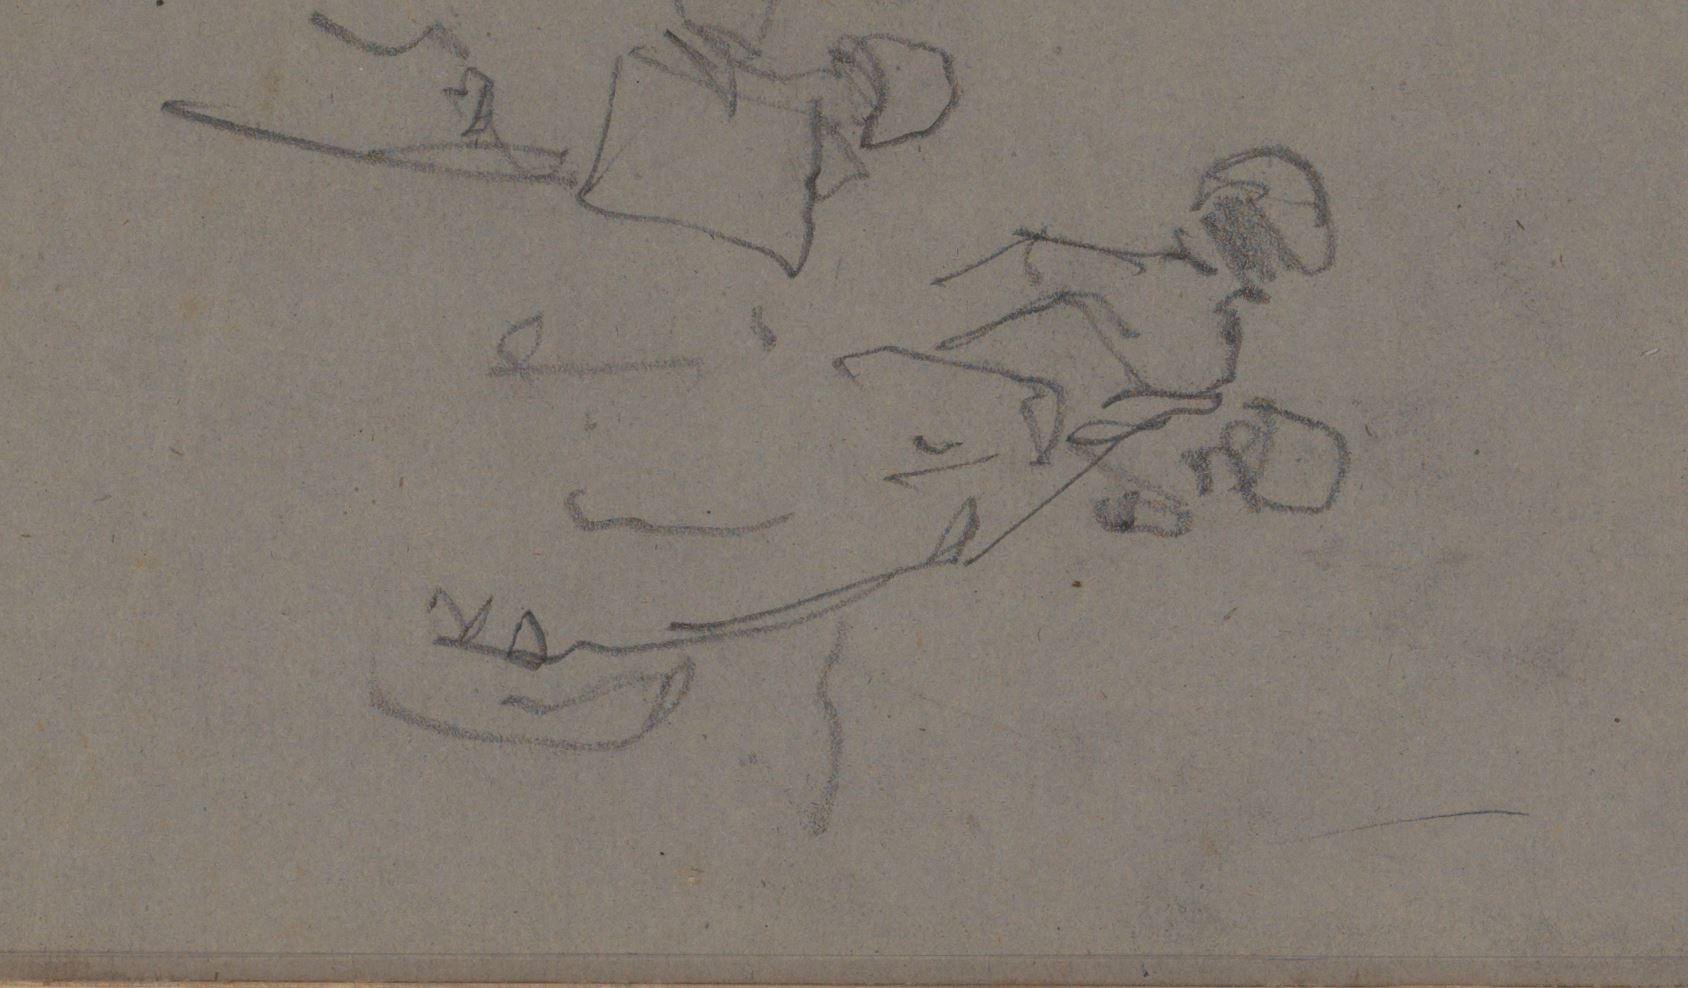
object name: sketchbook leaf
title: Figuurstudies, mogelijk van vrouwen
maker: george hendrik breitner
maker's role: draughtsman, painter, print maker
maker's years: 1857-1923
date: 1881-1883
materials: paper, pencil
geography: north brabant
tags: adult woman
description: Pagina 29 uit een schetsboek met 42 bladen.